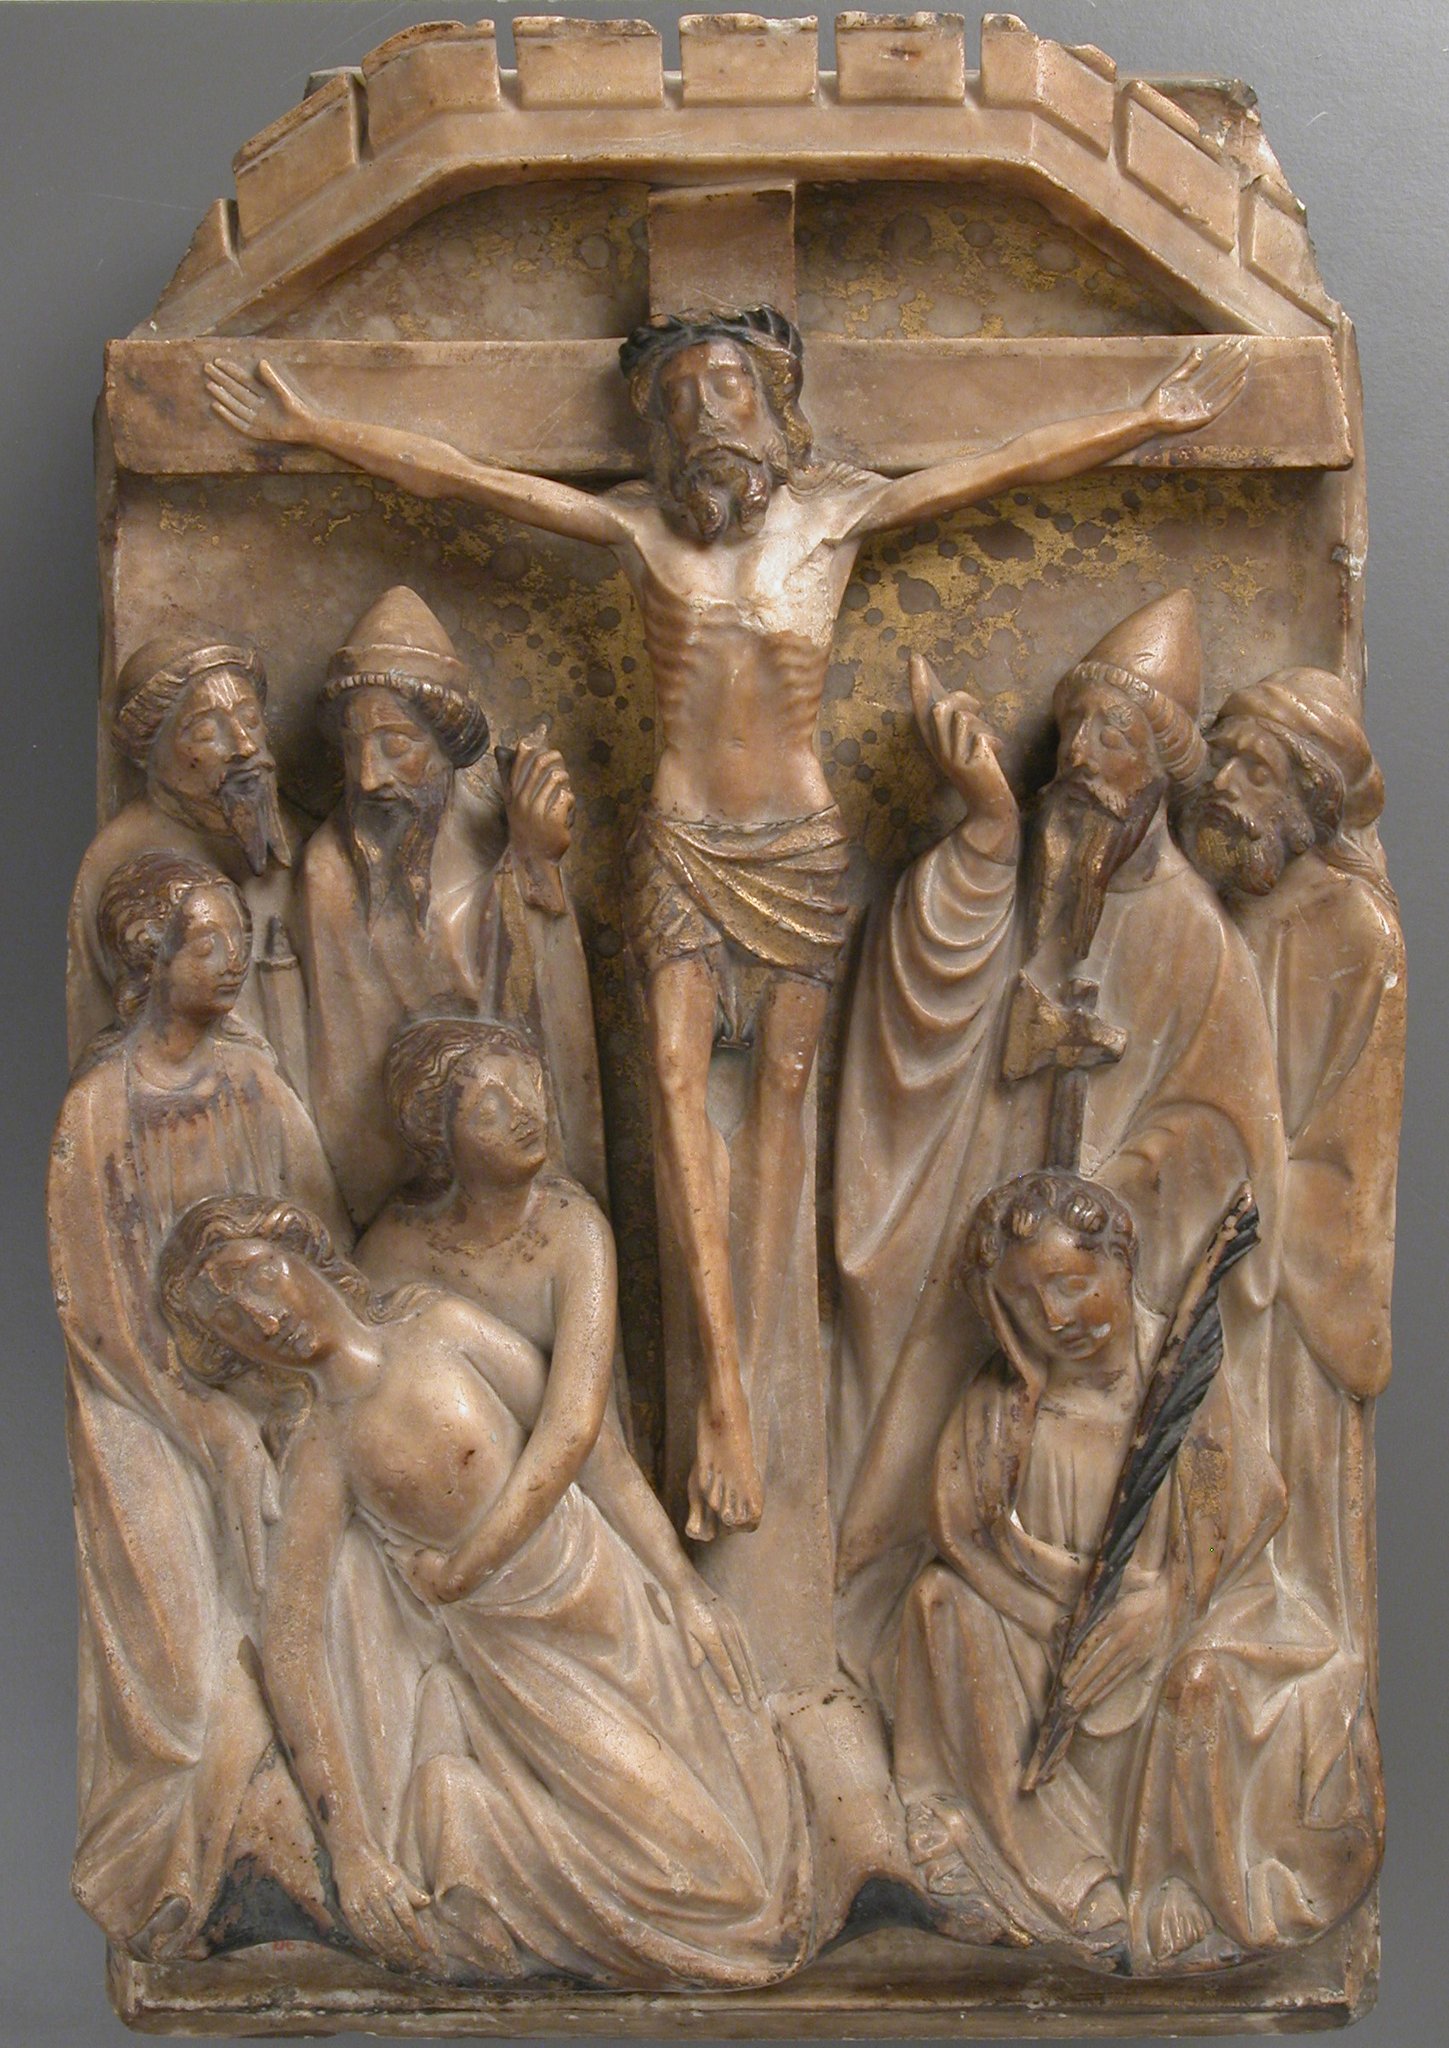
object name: panel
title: The Crucifixion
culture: british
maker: school of nottingham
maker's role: artist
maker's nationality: british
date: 1401-1500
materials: alabaster, paint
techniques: gilding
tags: men,christ,cross